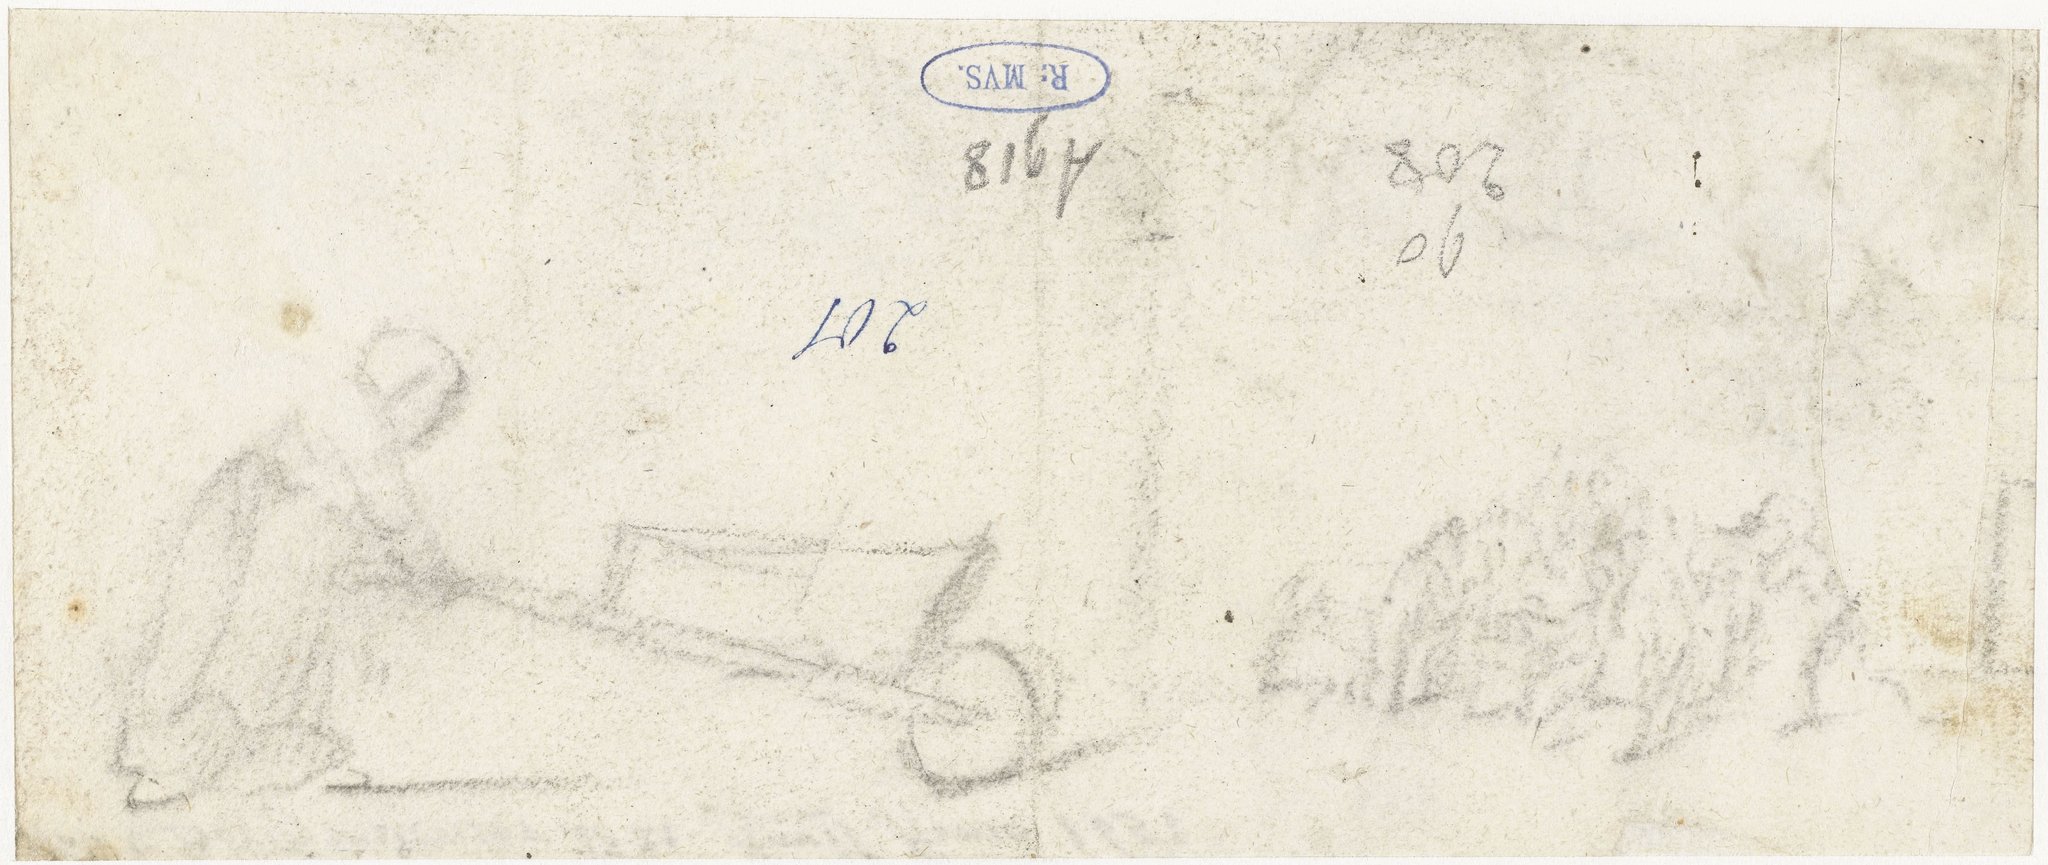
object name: drawing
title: Vrouw met een kruiwagen en een menigte bij een markt (?)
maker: harmen ter borch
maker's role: draughtsman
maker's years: 1638-1677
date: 1651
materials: chalk, paper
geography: zwolle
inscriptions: date